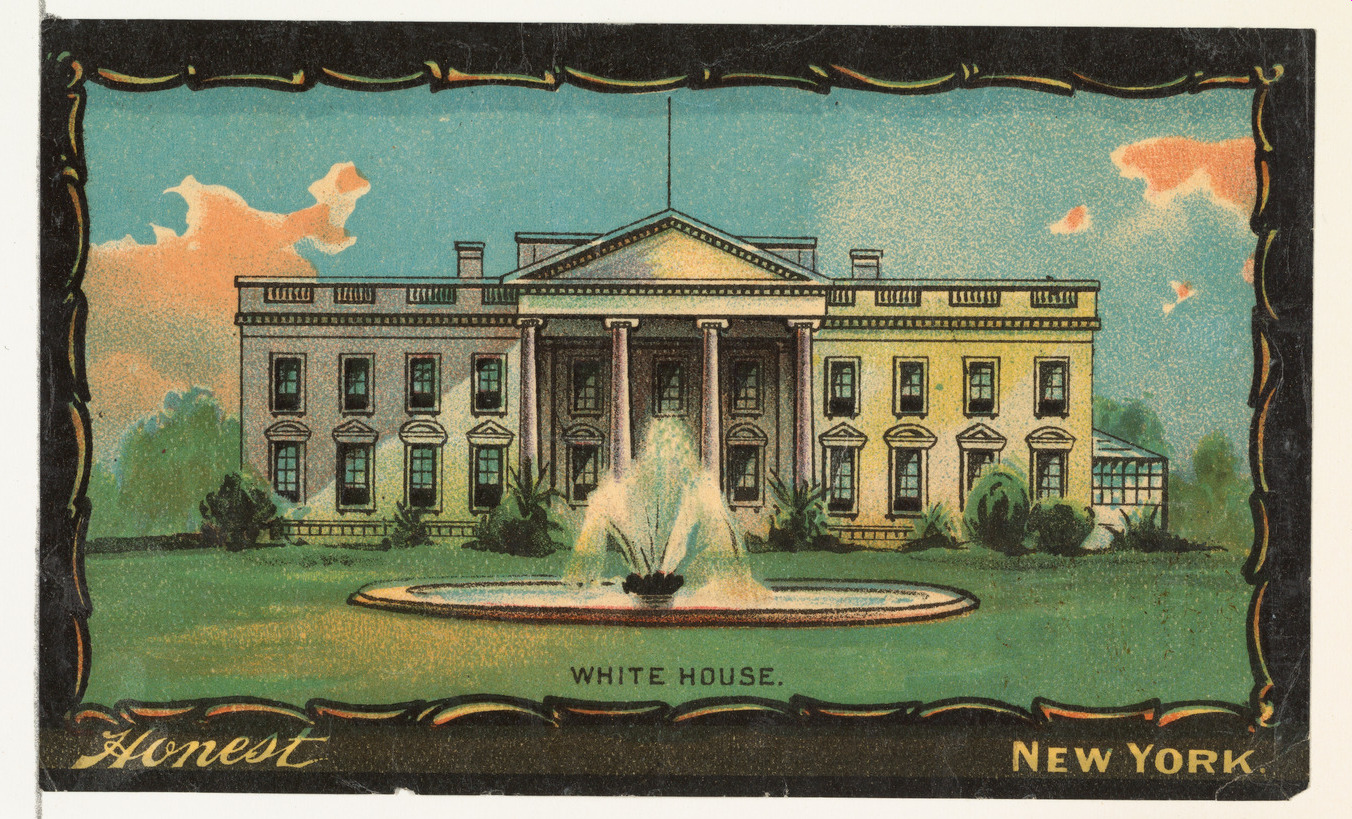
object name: print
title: The White House, Washington, D.C., from the Transparencies series (N137) issued by W. Duke, Sons & Co. to promote Honest Long Cut Tobacco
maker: w. duke, sons & co.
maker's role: publisher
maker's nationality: american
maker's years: 1870-1920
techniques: color lithograph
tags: buildings